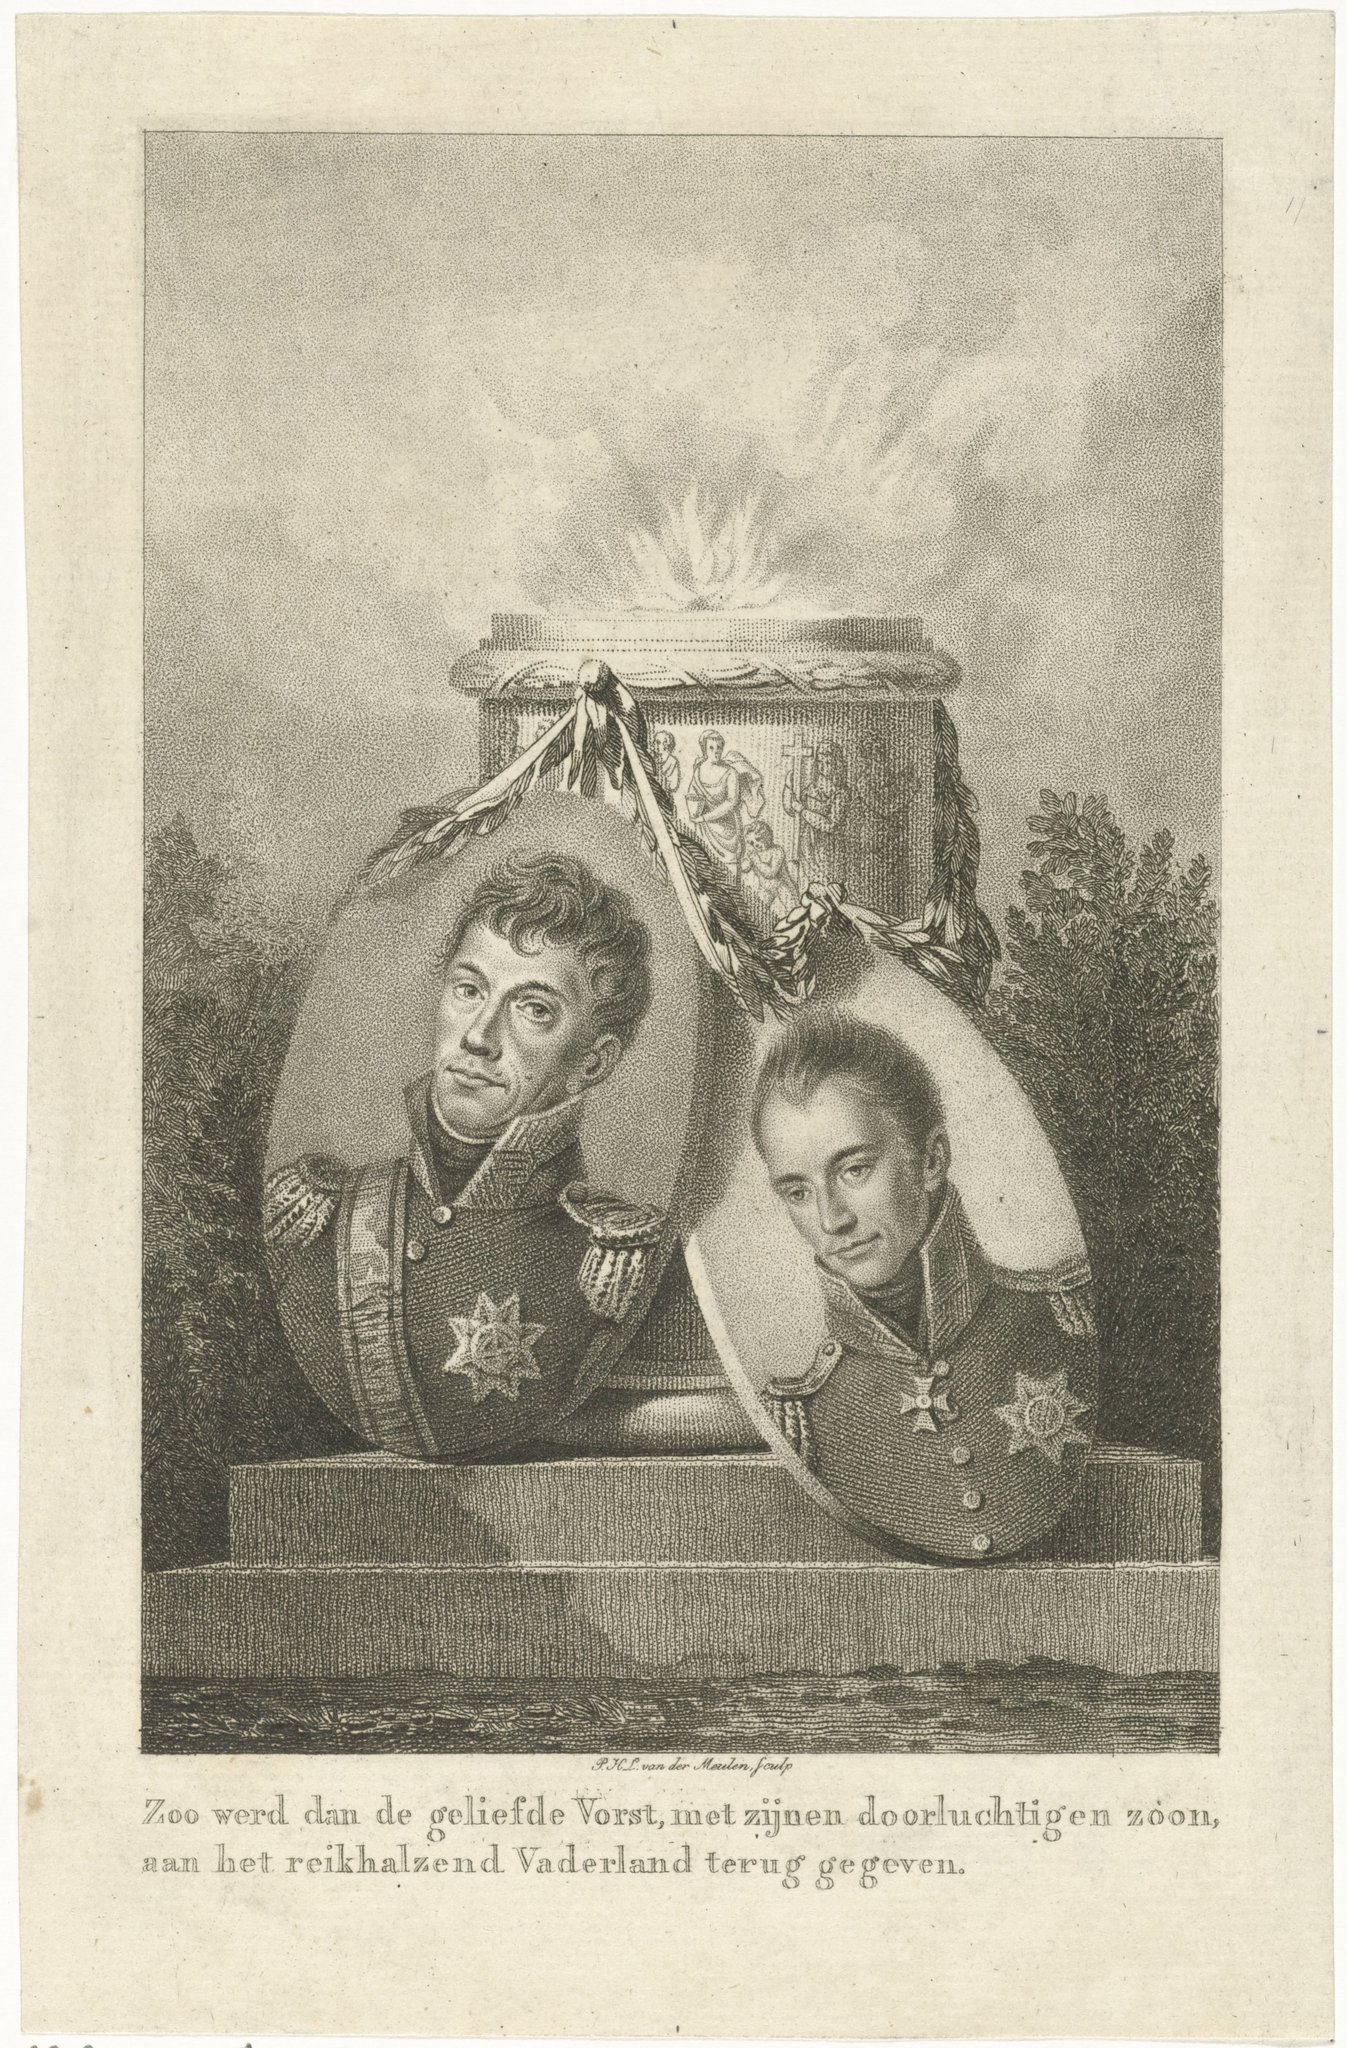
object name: print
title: Offerzuil met de portretten van Koning Willem I en kroonprins Willem II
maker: pieter van der meulen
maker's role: draughtsman, painter, print maker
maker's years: 1780-1858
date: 1813-1815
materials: paper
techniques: stippled etching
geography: amsterdam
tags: the hague, berlin, william i of the netherlands, william ii of the netherlands, offering; 'offerta overo oblatione' (ripa)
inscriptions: collector's mark: Lugt 2228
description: Offerzuil ter ere van de terugkeer van Willem I en zijn zoon Willem II in 1813 in de Nederlanden. Tegen de zuil de portretten van Willem I en Willem II.